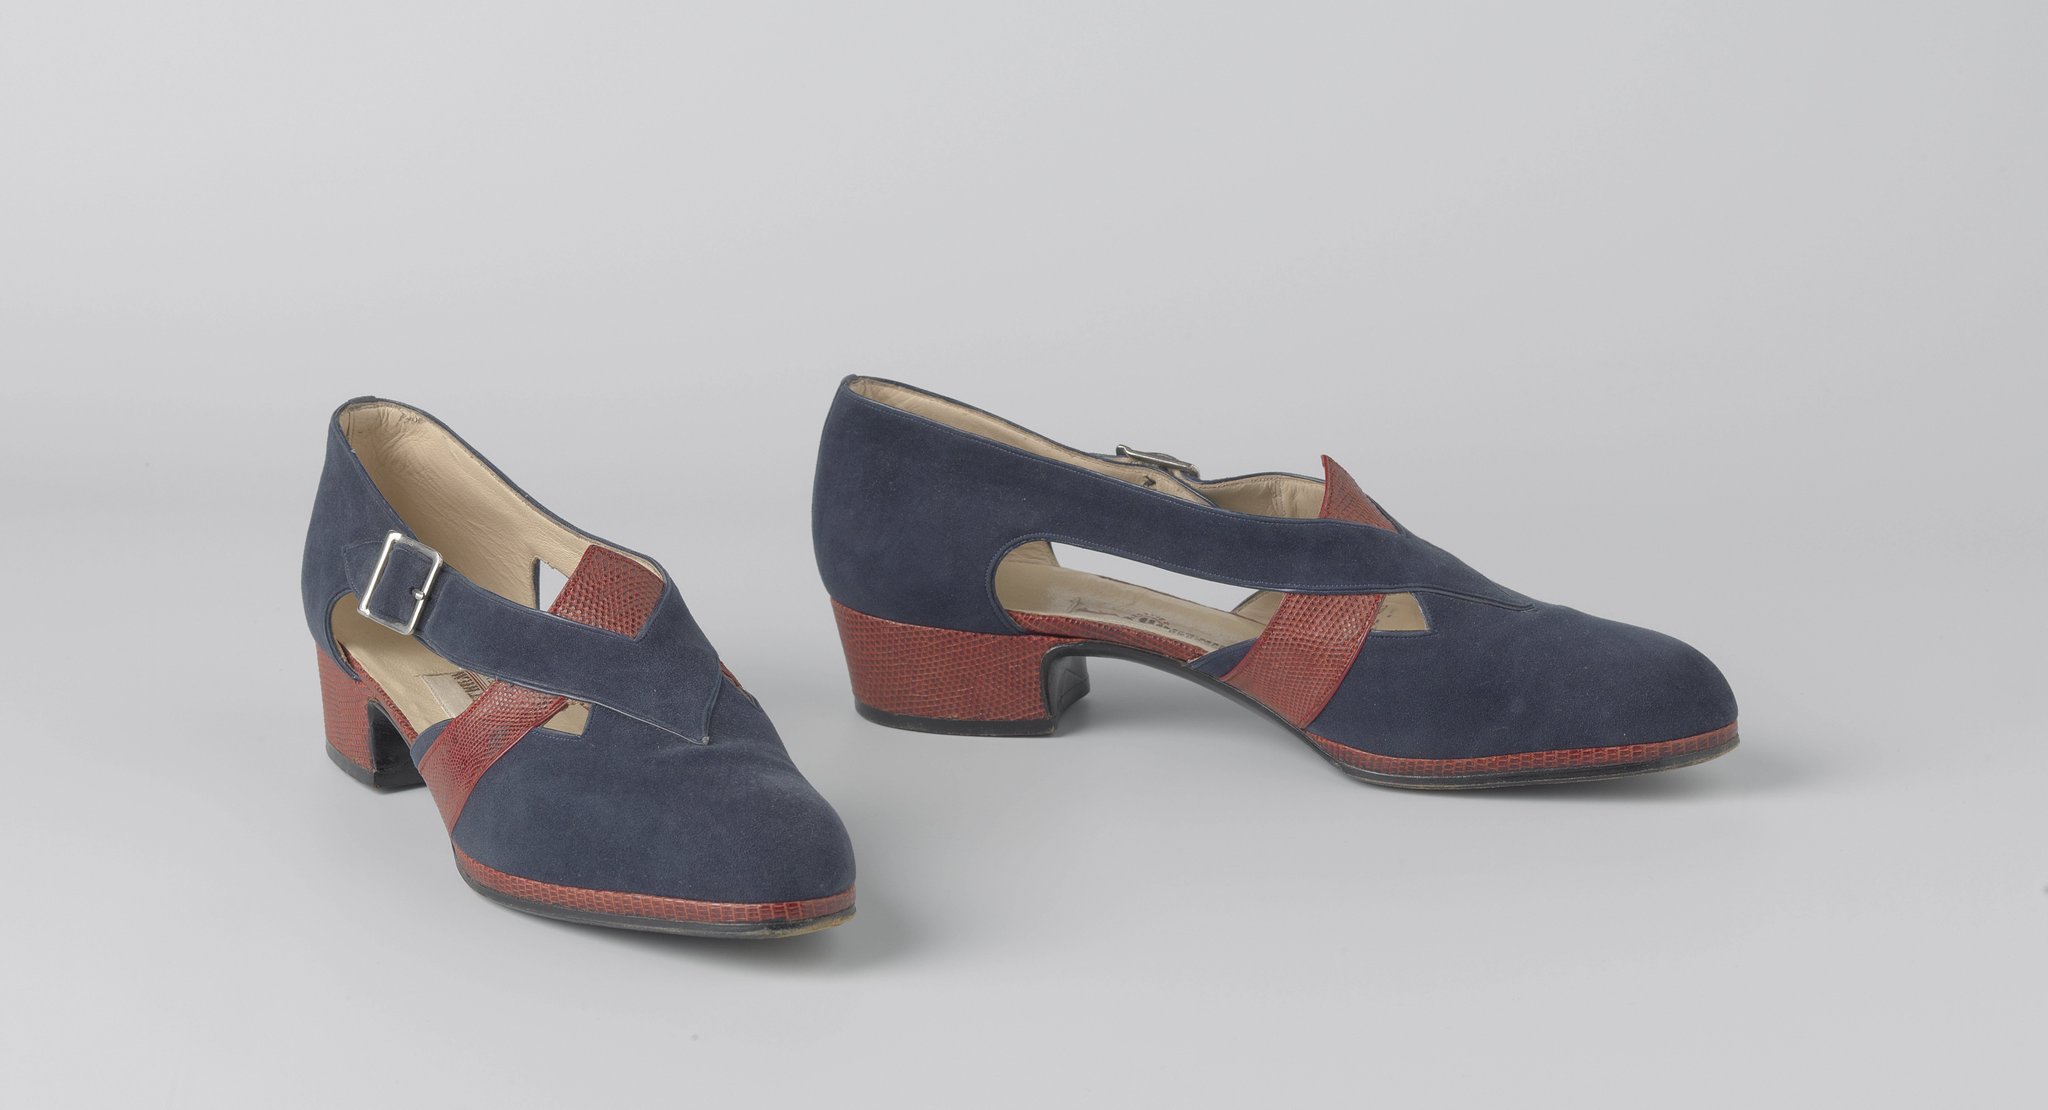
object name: womenswear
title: Schoen van donkerblauw suède, open model versierd met rood krokodillenleer, voorzien van gespsluiting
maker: a. van goethem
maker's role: schoenmaker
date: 1930-1970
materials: cotton, leather, metal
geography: brussels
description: Linker schoen van donkerblauw suède versierd met rood krokodillenleer. Model: voorblad is op de voorvoet in twee punten uitgesneden. De zijpanden zijn weggesneden zodat alleen een hielpand overblijft. De hielpanden vormen een 2 cm brede v-vormige band die aan de buitenkant van de voet sluit met een vierkante, metalen gesp. De punt van de v-vormige band is op het voorblad vastgestikt. Lage hak. De schoen is gevoerd met naturelkleurig leer. Naturel leren binnenzool waarin stoffen adres is gestikt. Versiering: onder de voorvoet een plateau van 50mm, bekleed met rood krokodillenleer. Ook de hak en het geleng bijn bekleed met dit leer. Onder en over het gekartelde voorblad is een 2.5 cm brede band van rood krokodillenleer gestikt. Adres (op stoffen label op binnenzool): BOTTIER/A.VAN GOETHEM/BRUXELLES.